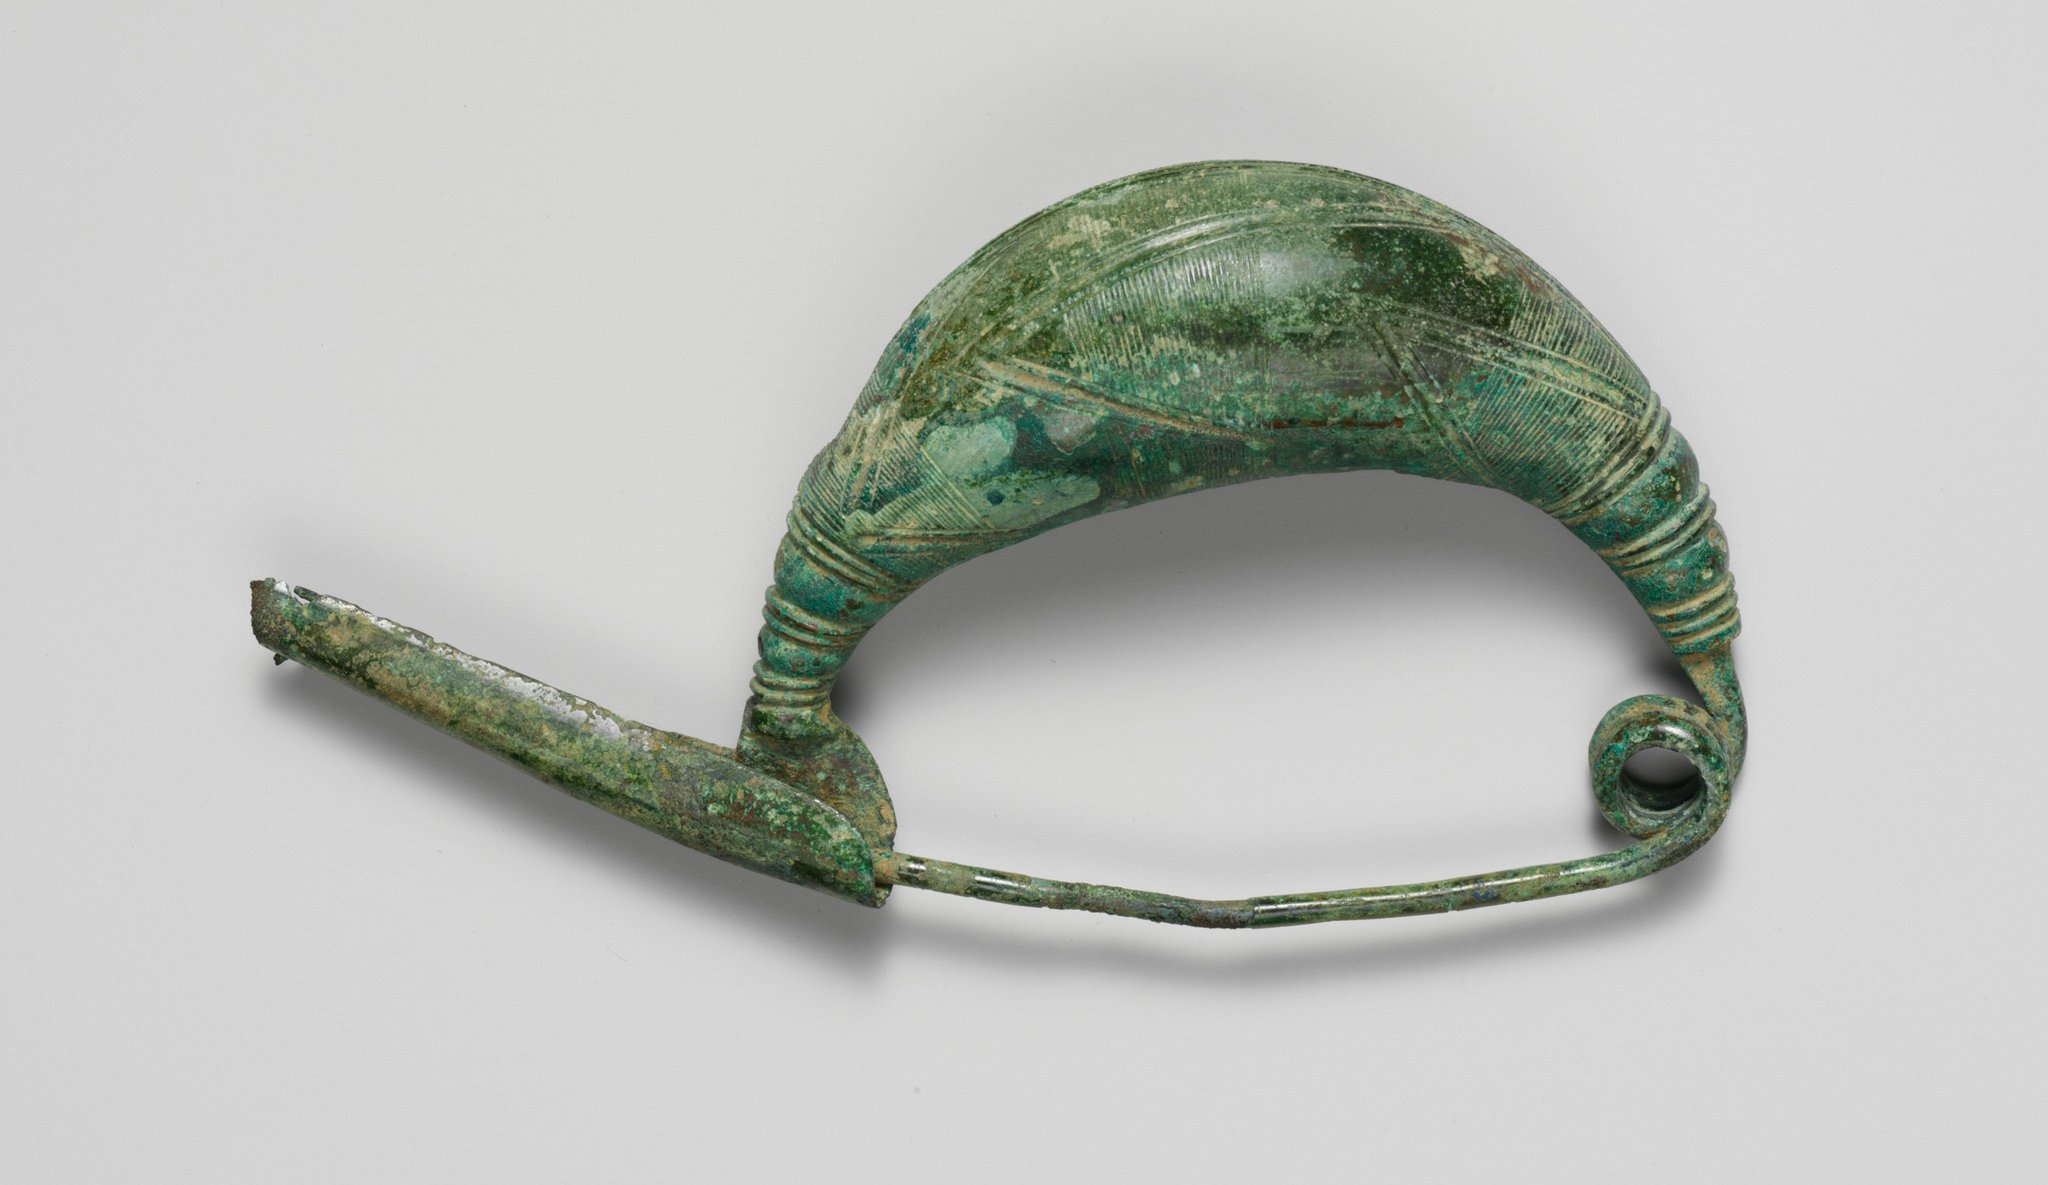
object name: fibula, sanguisuga type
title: Bronze sanguisuga-type fibula (safety pin)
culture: etruscan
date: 700-601 BCE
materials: bronze